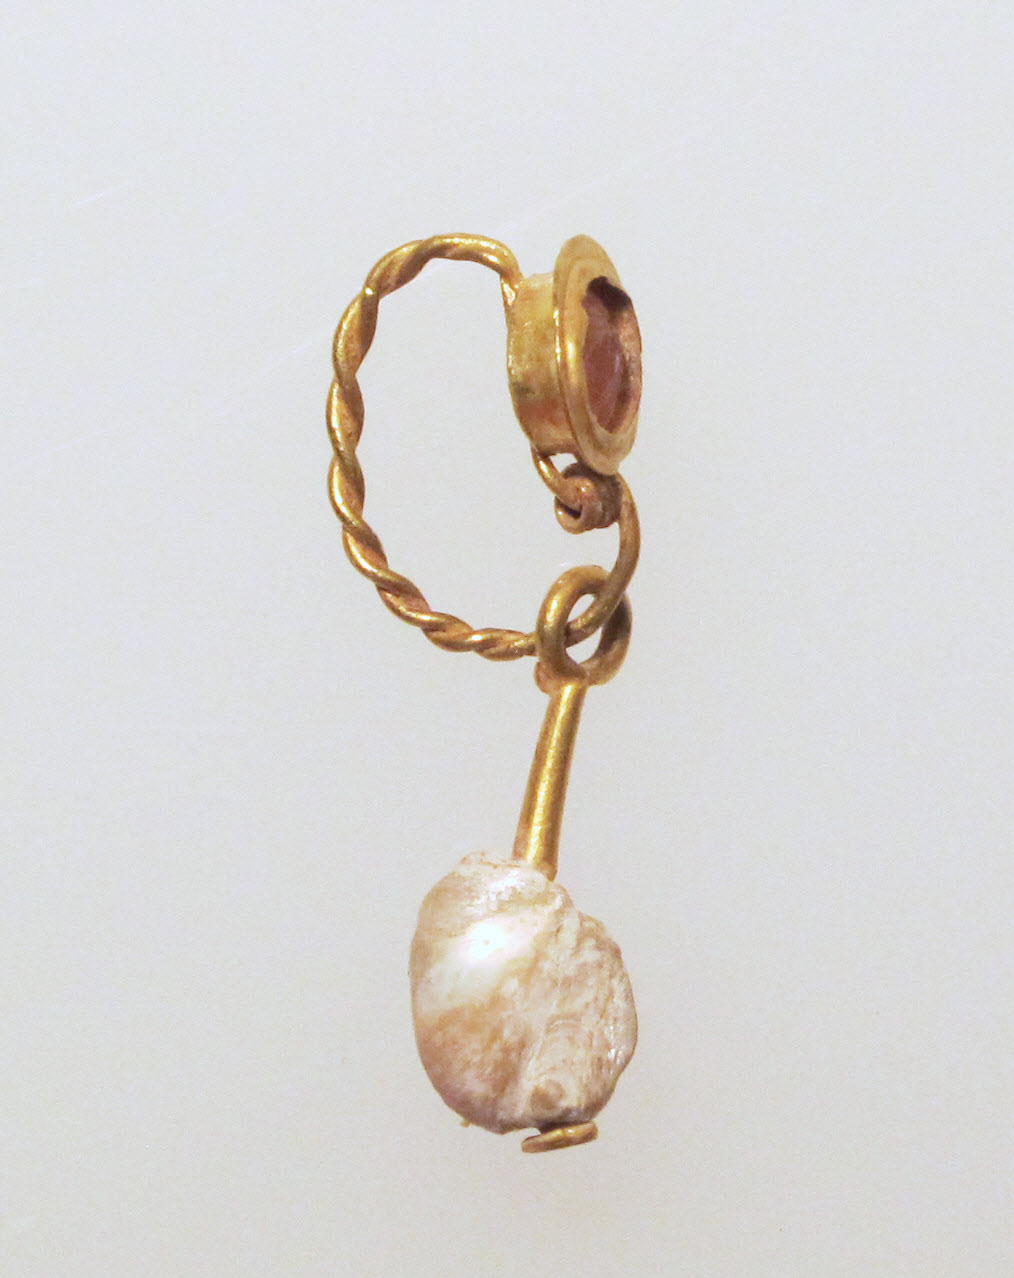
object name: earring with pendant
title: Gold earring with sard setting and pearl pendant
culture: roman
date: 670 BCE-330 CE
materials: gold